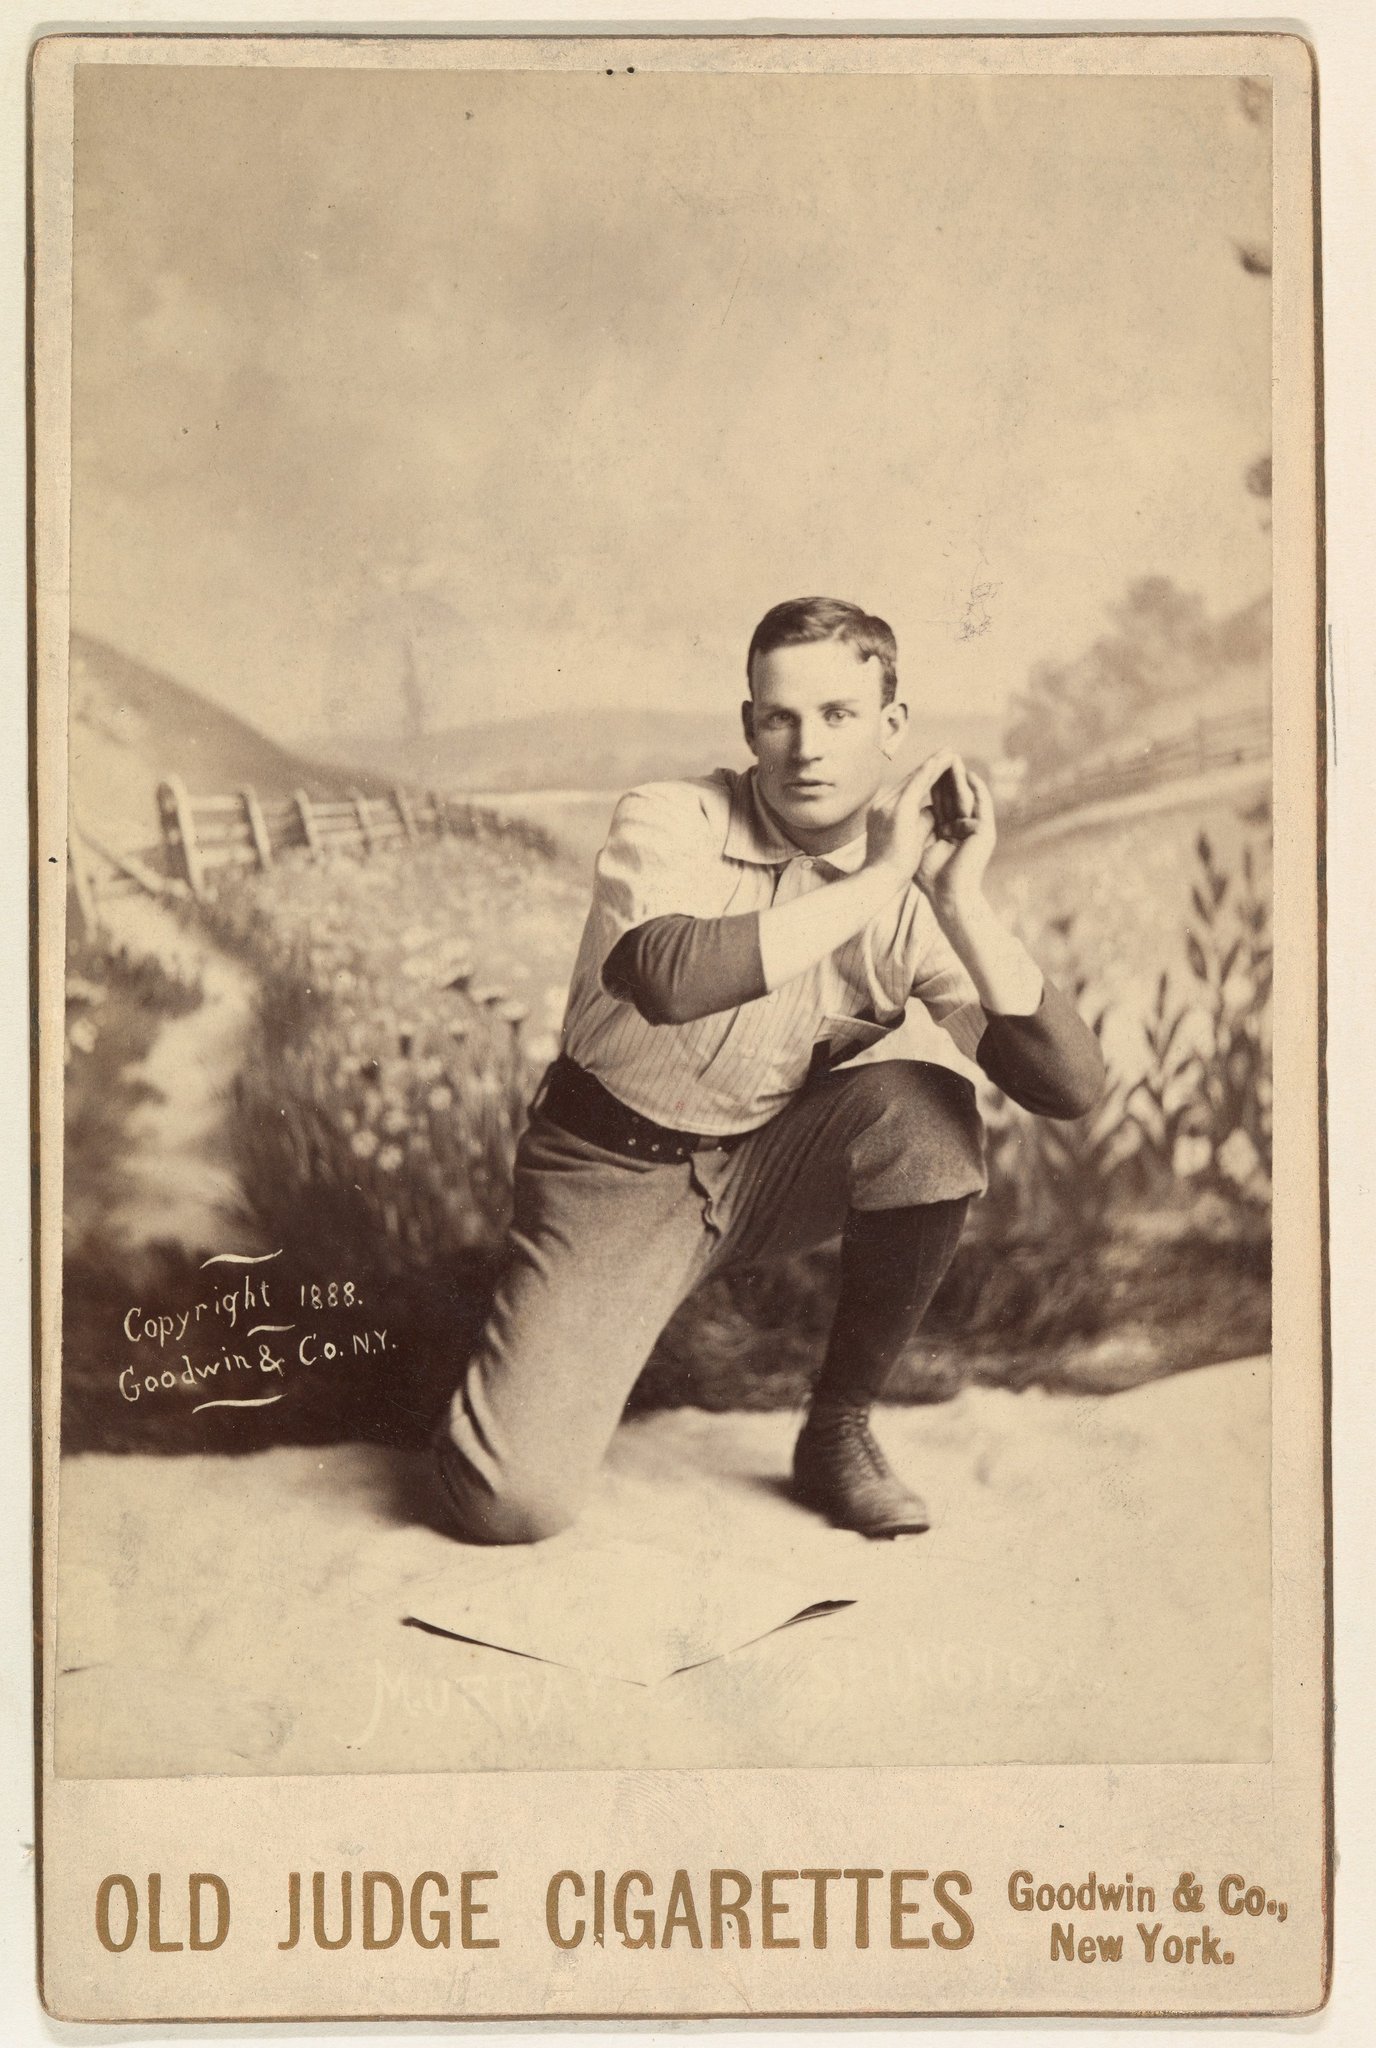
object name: baseball card, photograph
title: Murray, Washington, from the series Old Judge Cigarettes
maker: goodwin & company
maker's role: publisher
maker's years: 1850-1950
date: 1888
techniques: albumen print, photography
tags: men,portraits,baseball,athletes